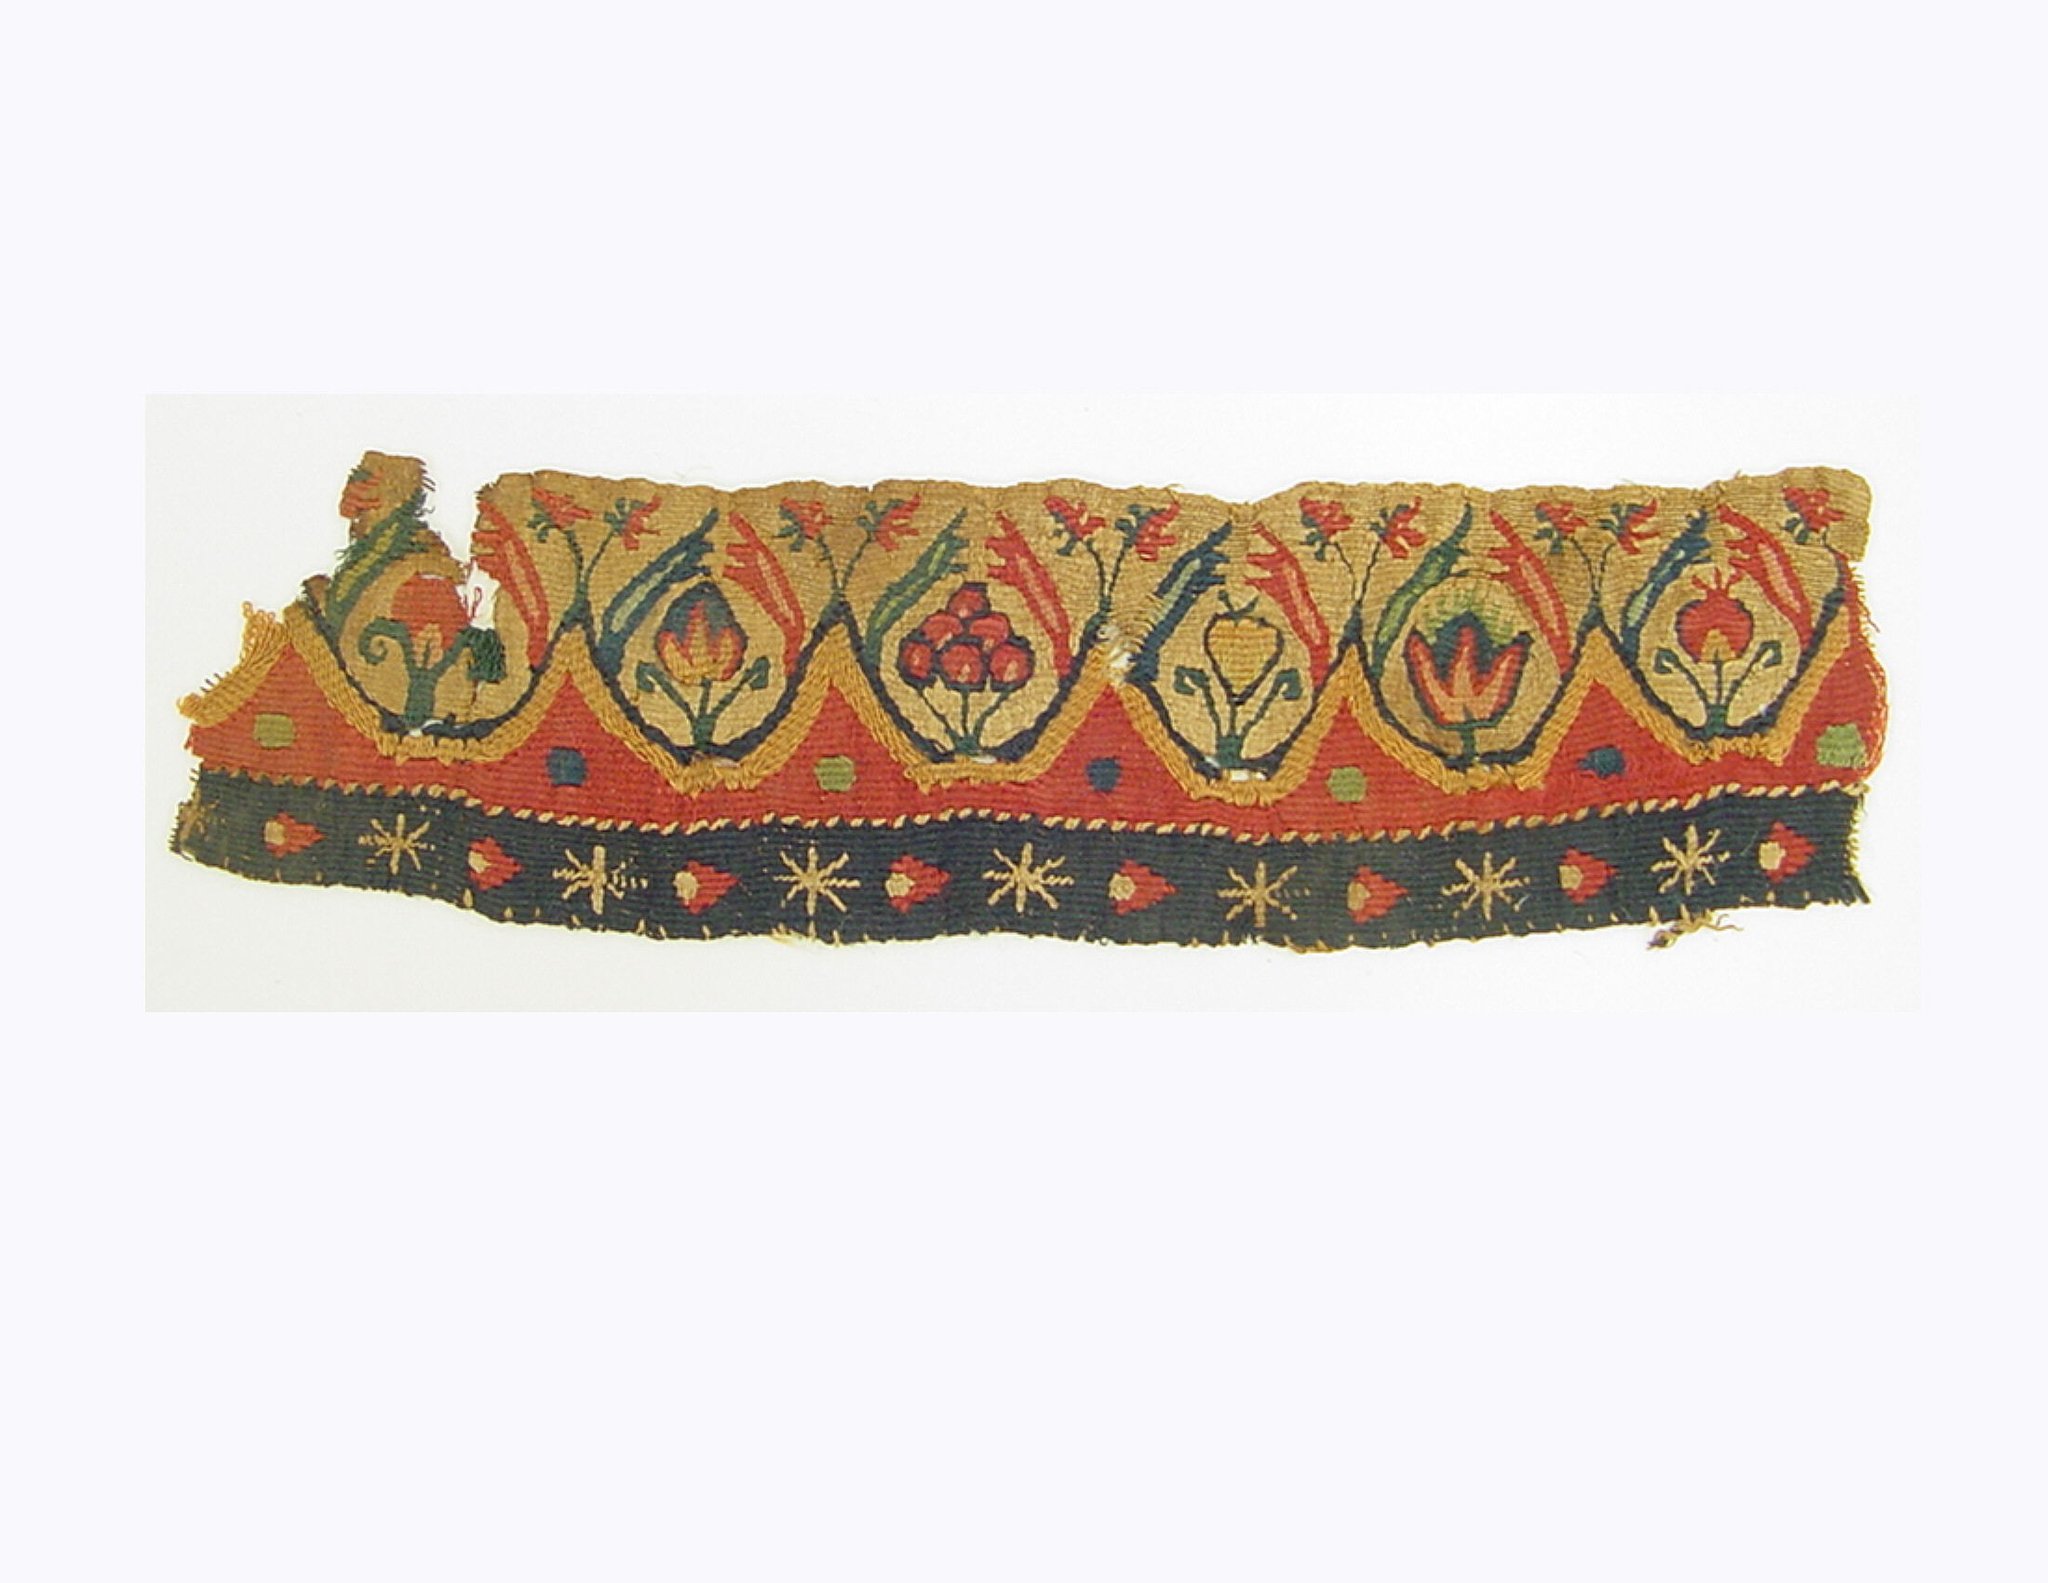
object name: textile fragment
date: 301-500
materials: linen, wool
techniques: weave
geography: egypt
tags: flowers